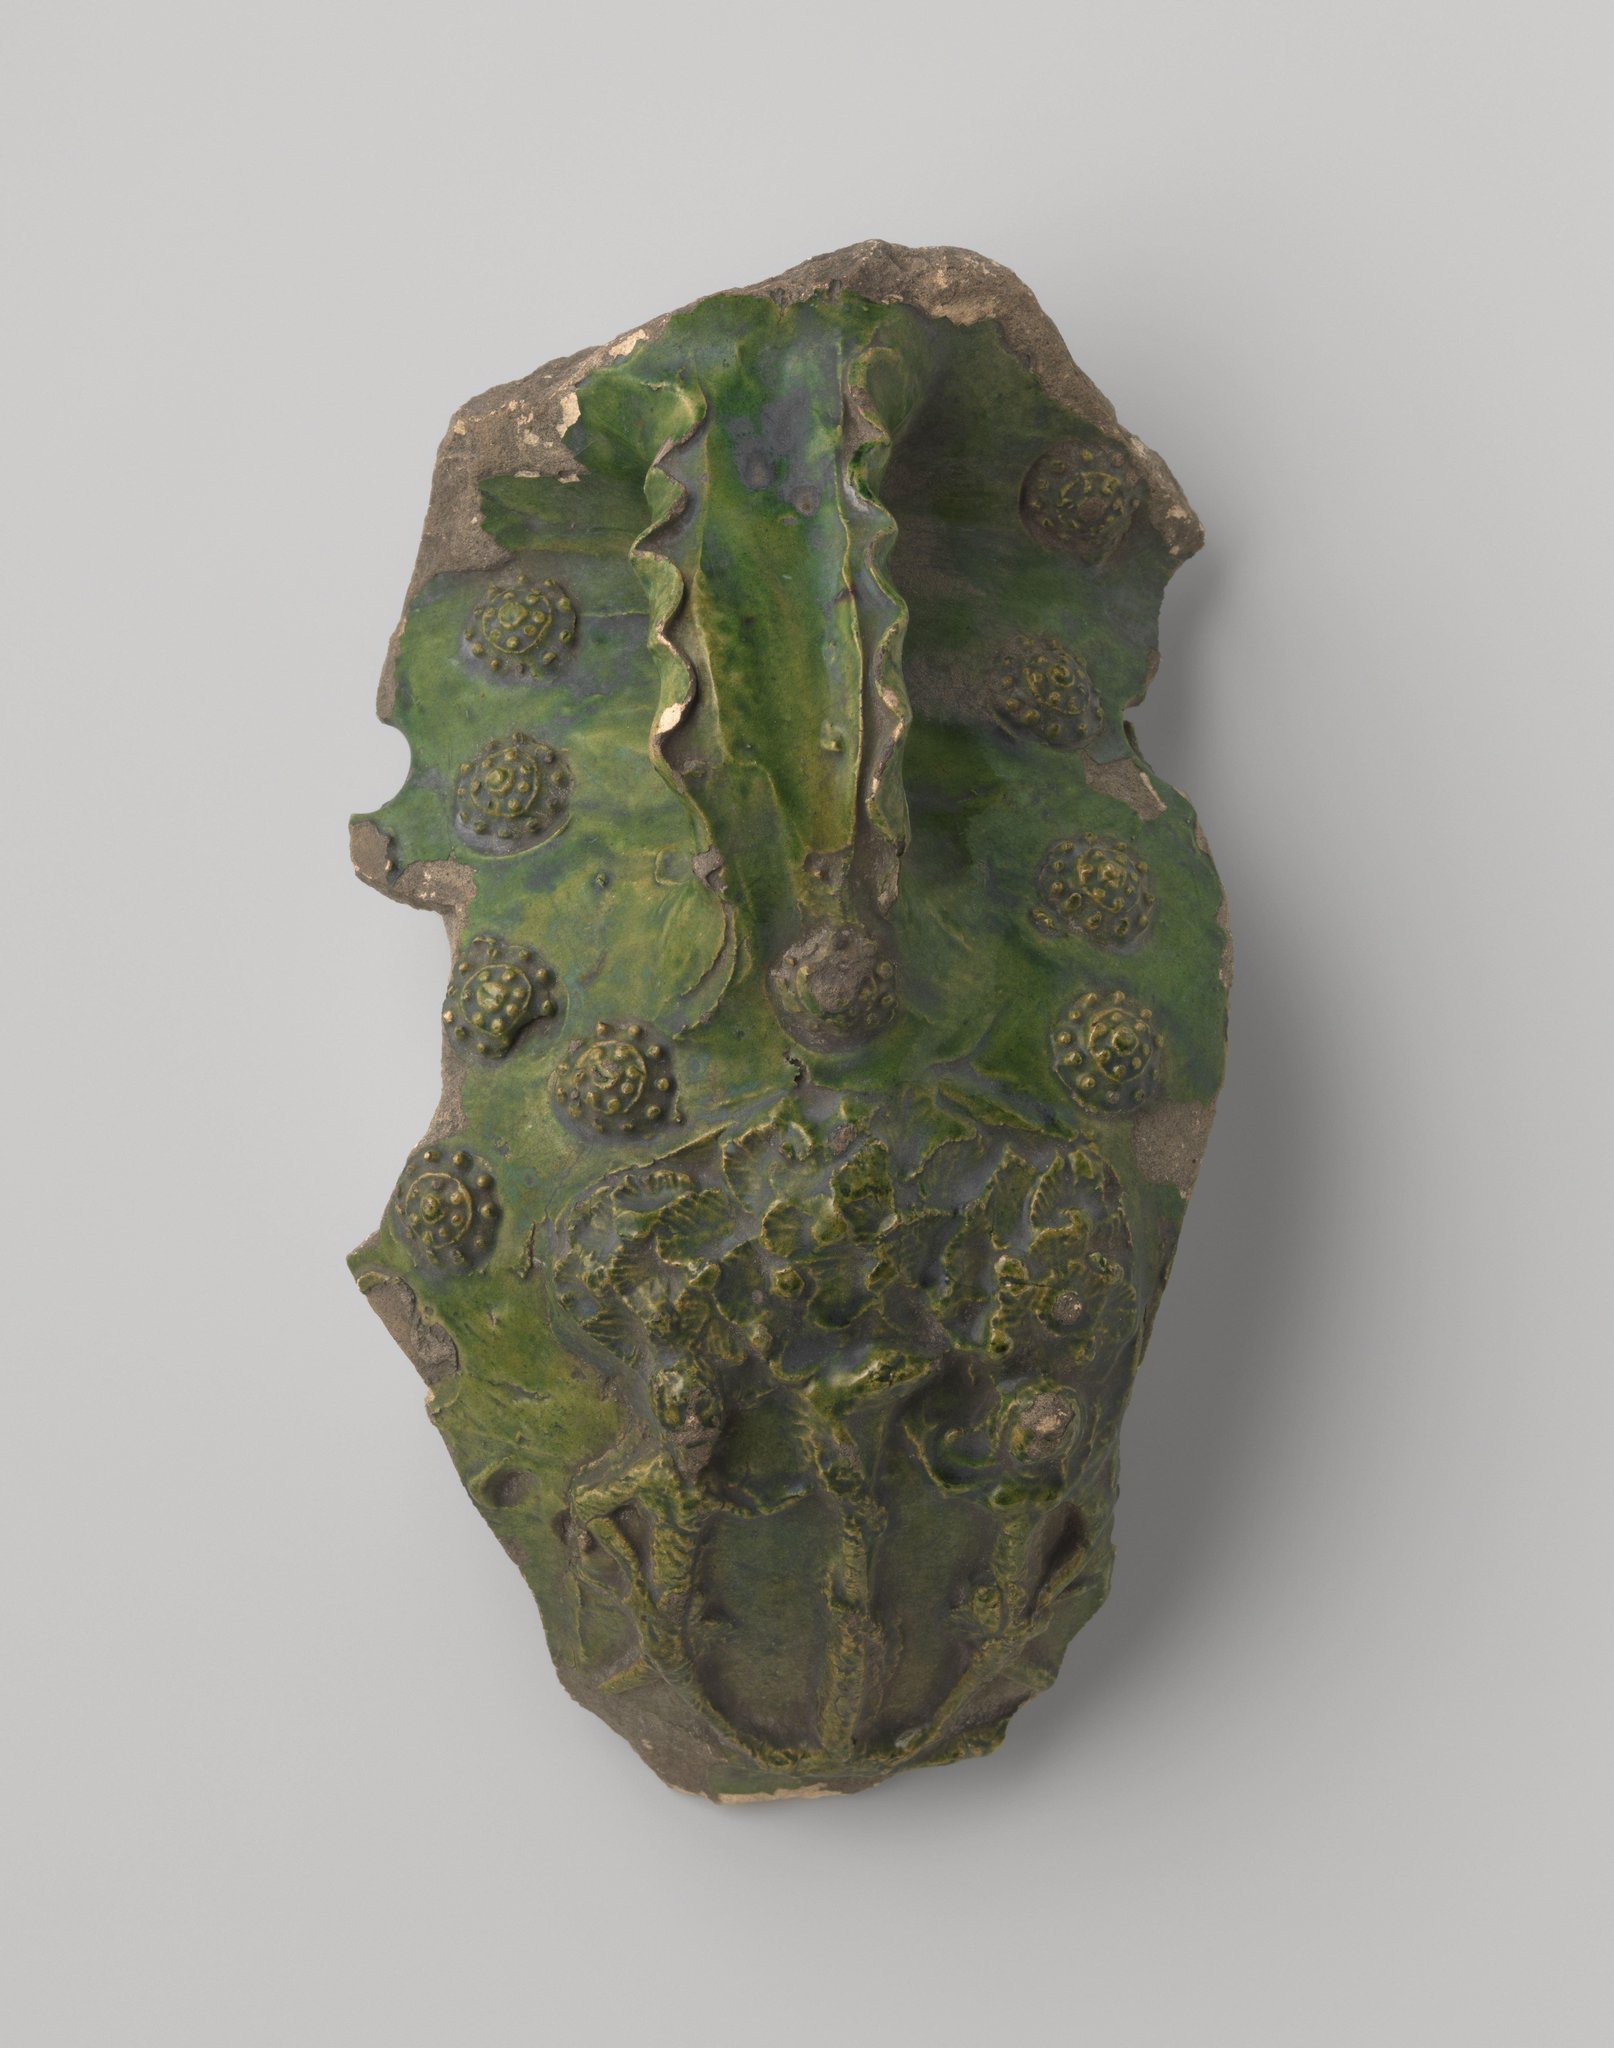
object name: fragment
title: Fragment met oor van een pot (?) met Adam en Eva en de boom met de slang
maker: Anonymous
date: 1400-1950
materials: earthenware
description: Fragment met oor van een pot (?) van groengeglazuurd aardewerk met Adam en Eva en de boom met de slang, in relief.